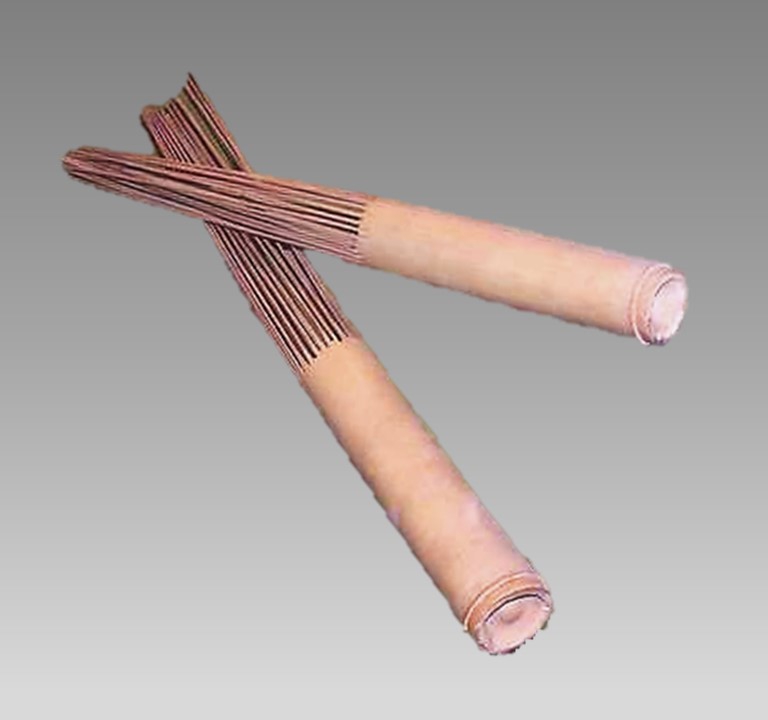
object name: pu'ili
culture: hawaiian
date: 1801-1900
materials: bamboo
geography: united states